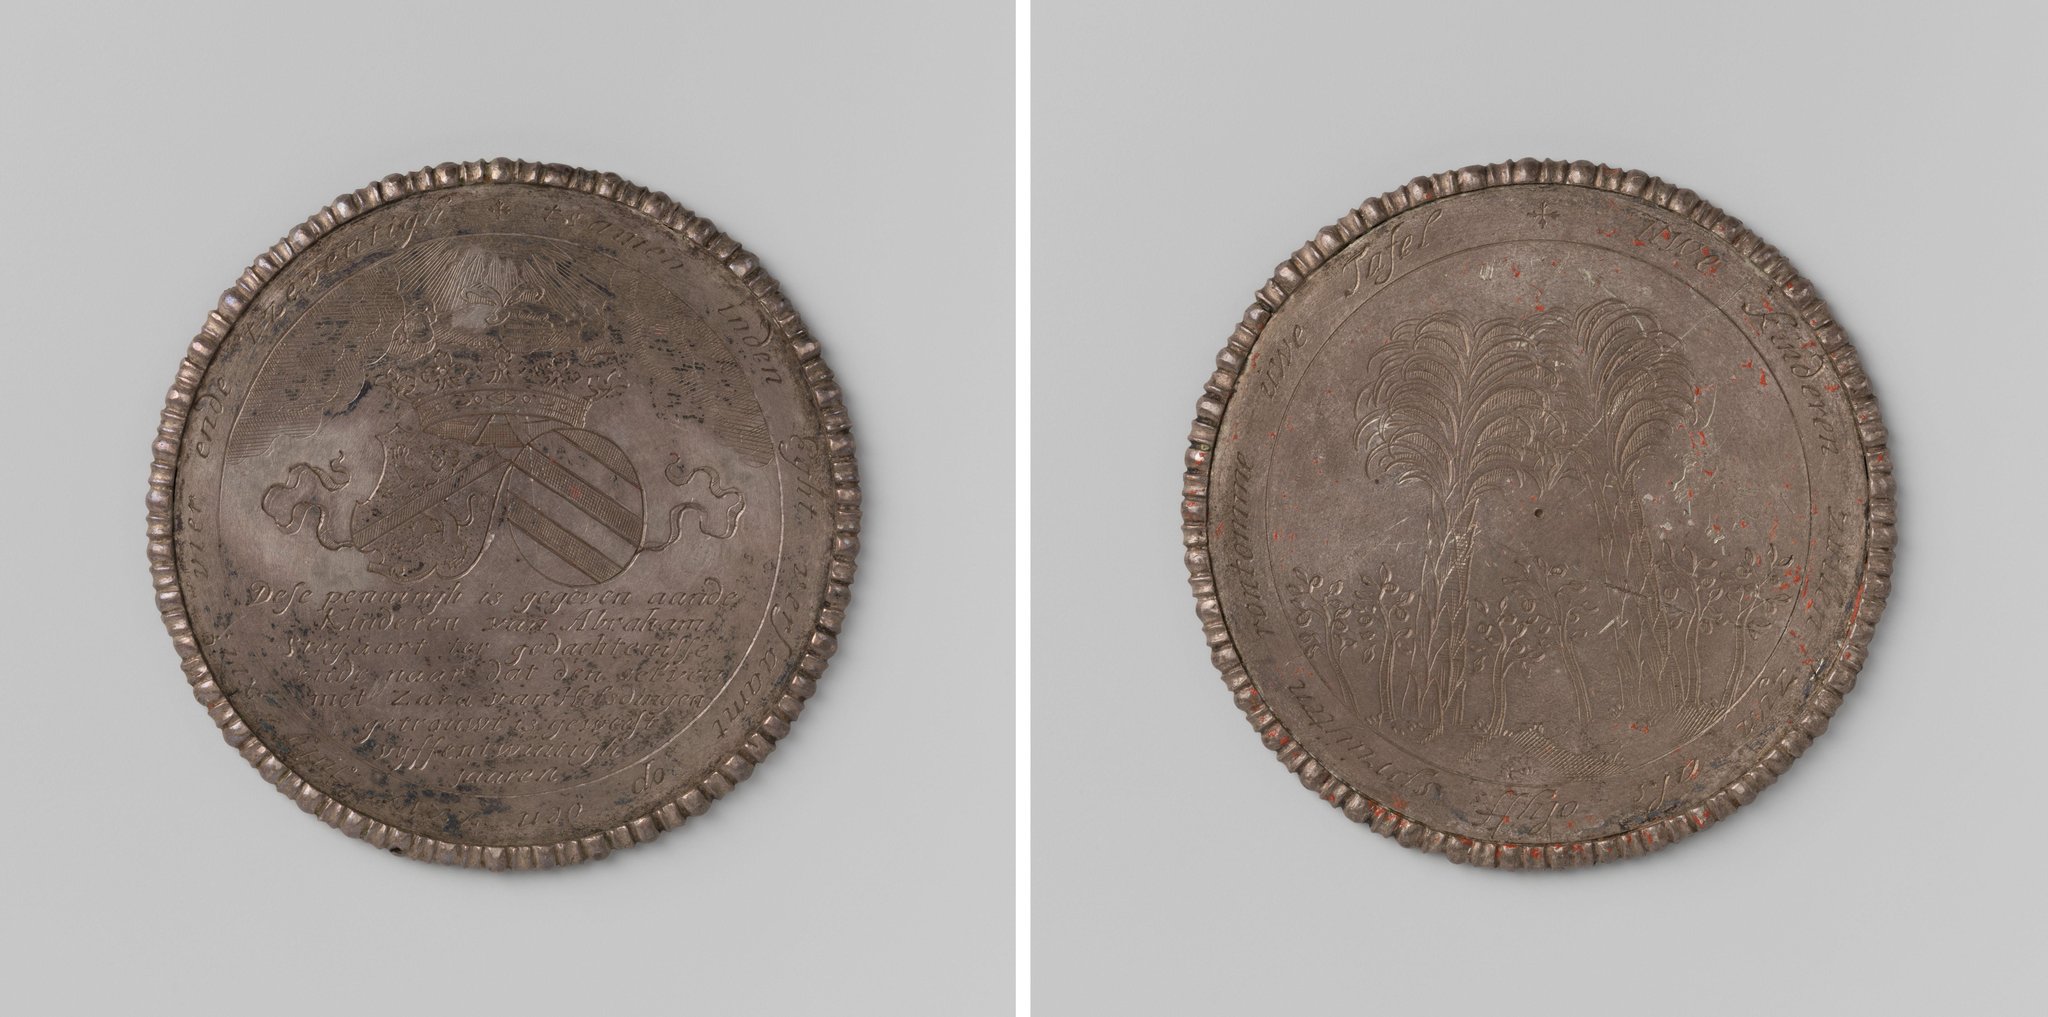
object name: family medal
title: Vijfentwintigjarig huwelijk van Abraham Steijaart en Zara van Helsdingen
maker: a. van tilburg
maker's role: medailleur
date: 1699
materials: silver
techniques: engraving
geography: netherlands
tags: abraham steijaart, zara van helsdingen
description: Zilveren penning met kabelrand. Voorzijde: twee ineengeslagen handen uit wolken houden lint vast waaraan twee wapenschilden vastgebonden zijn onder een kroon boven opschrift, binnen omschrift. Keerzijde: twee naar elkaar toe groeiende palmbomen binnen opschrift